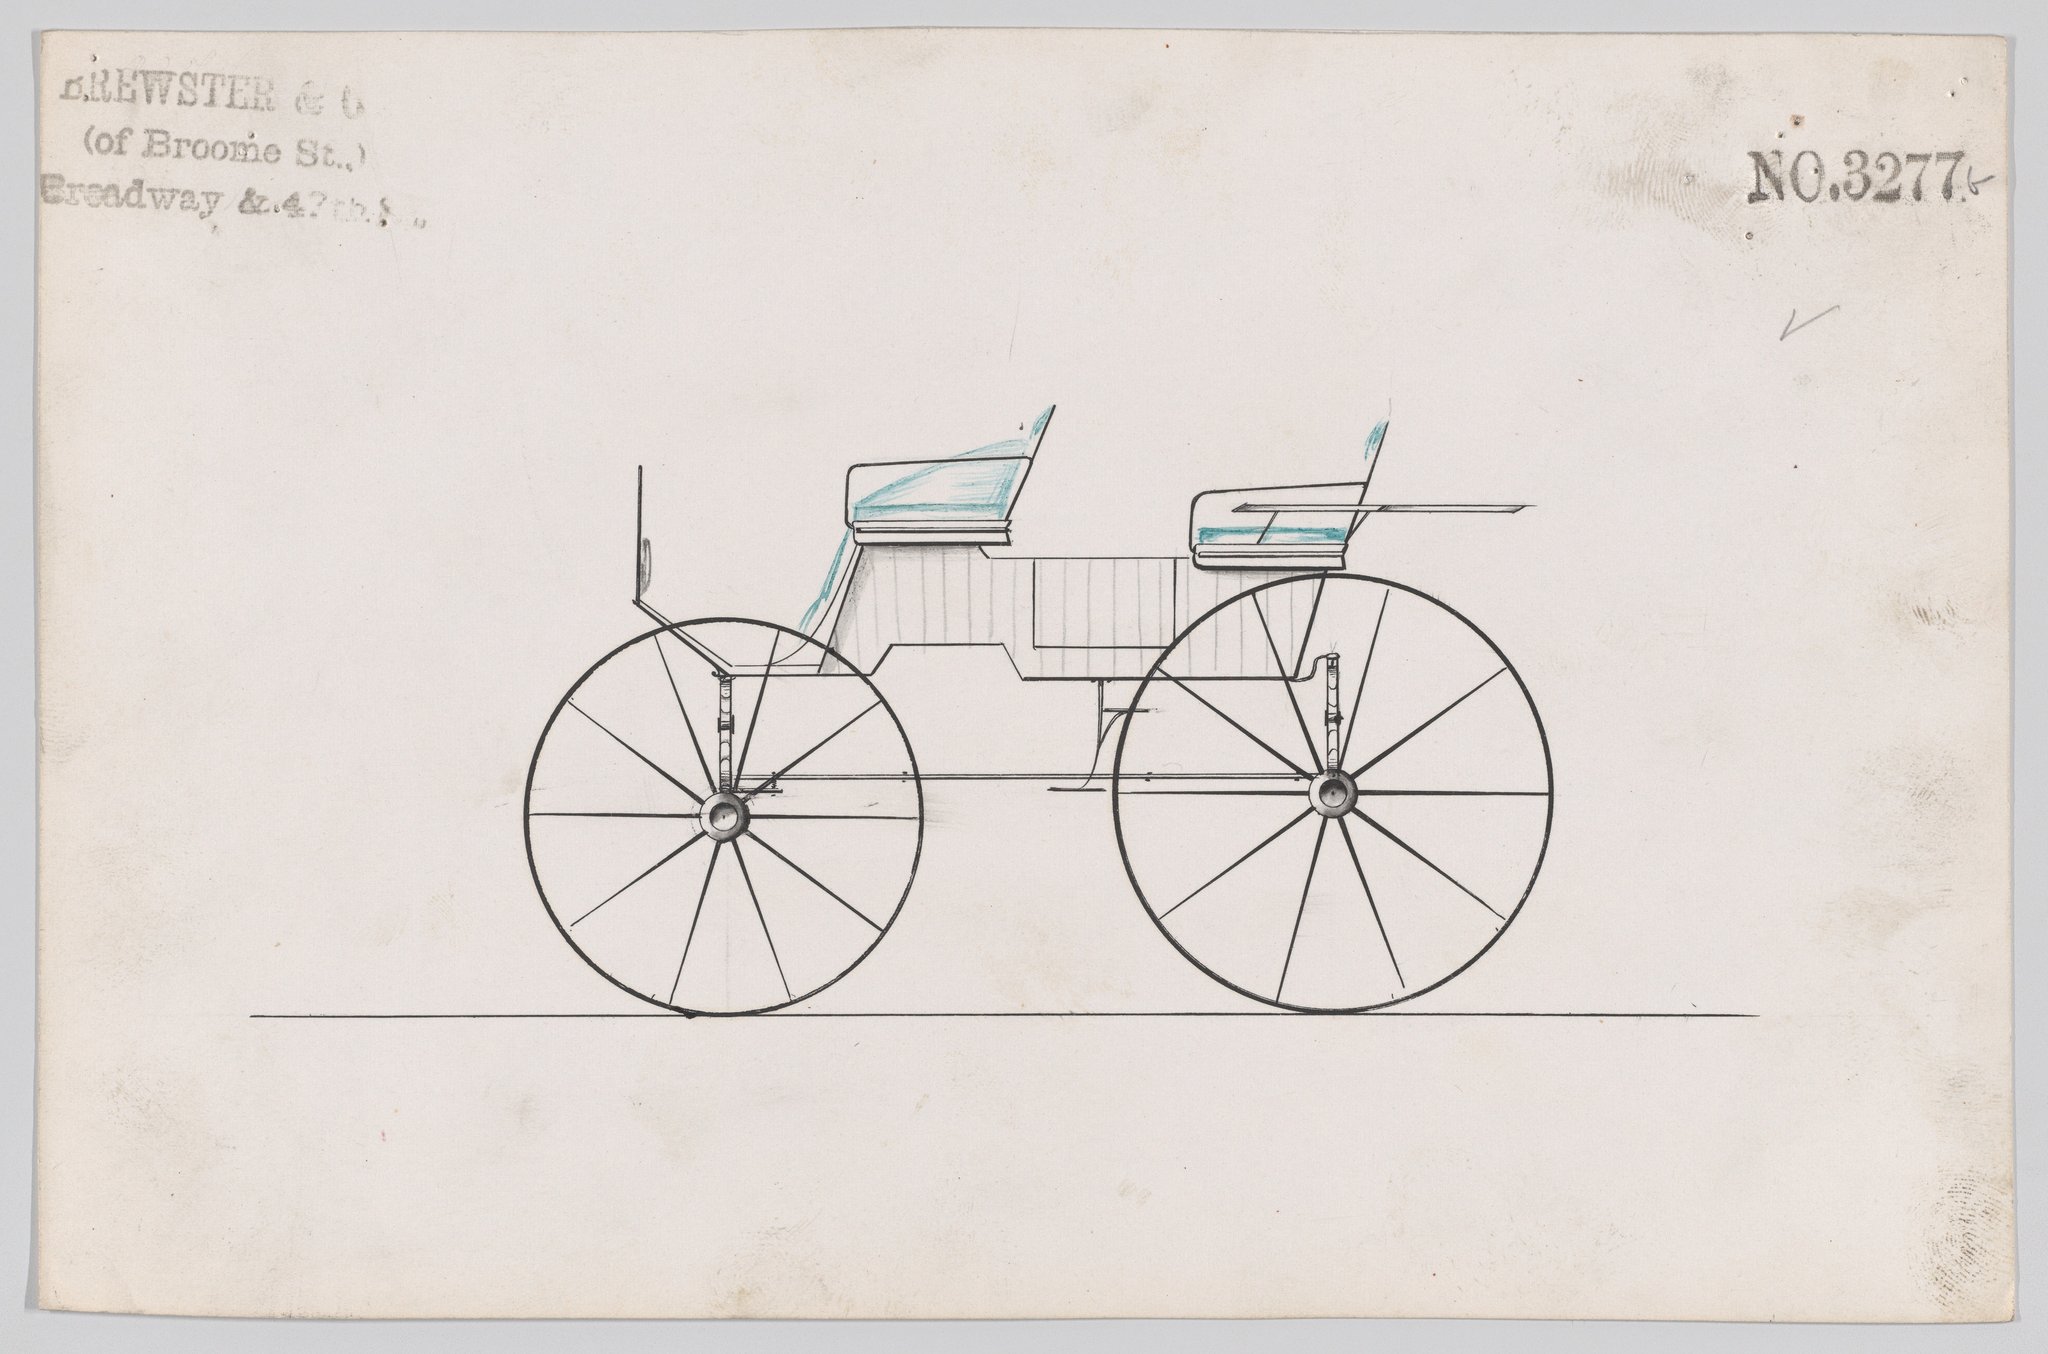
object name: drawing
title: Design for 4 seat Phaeton, no top, no. 3277b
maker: brewster & co.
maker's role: manufacturer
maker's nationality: american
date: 1850-1910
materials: gouache, ink, watercolor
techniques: pen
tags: carriages